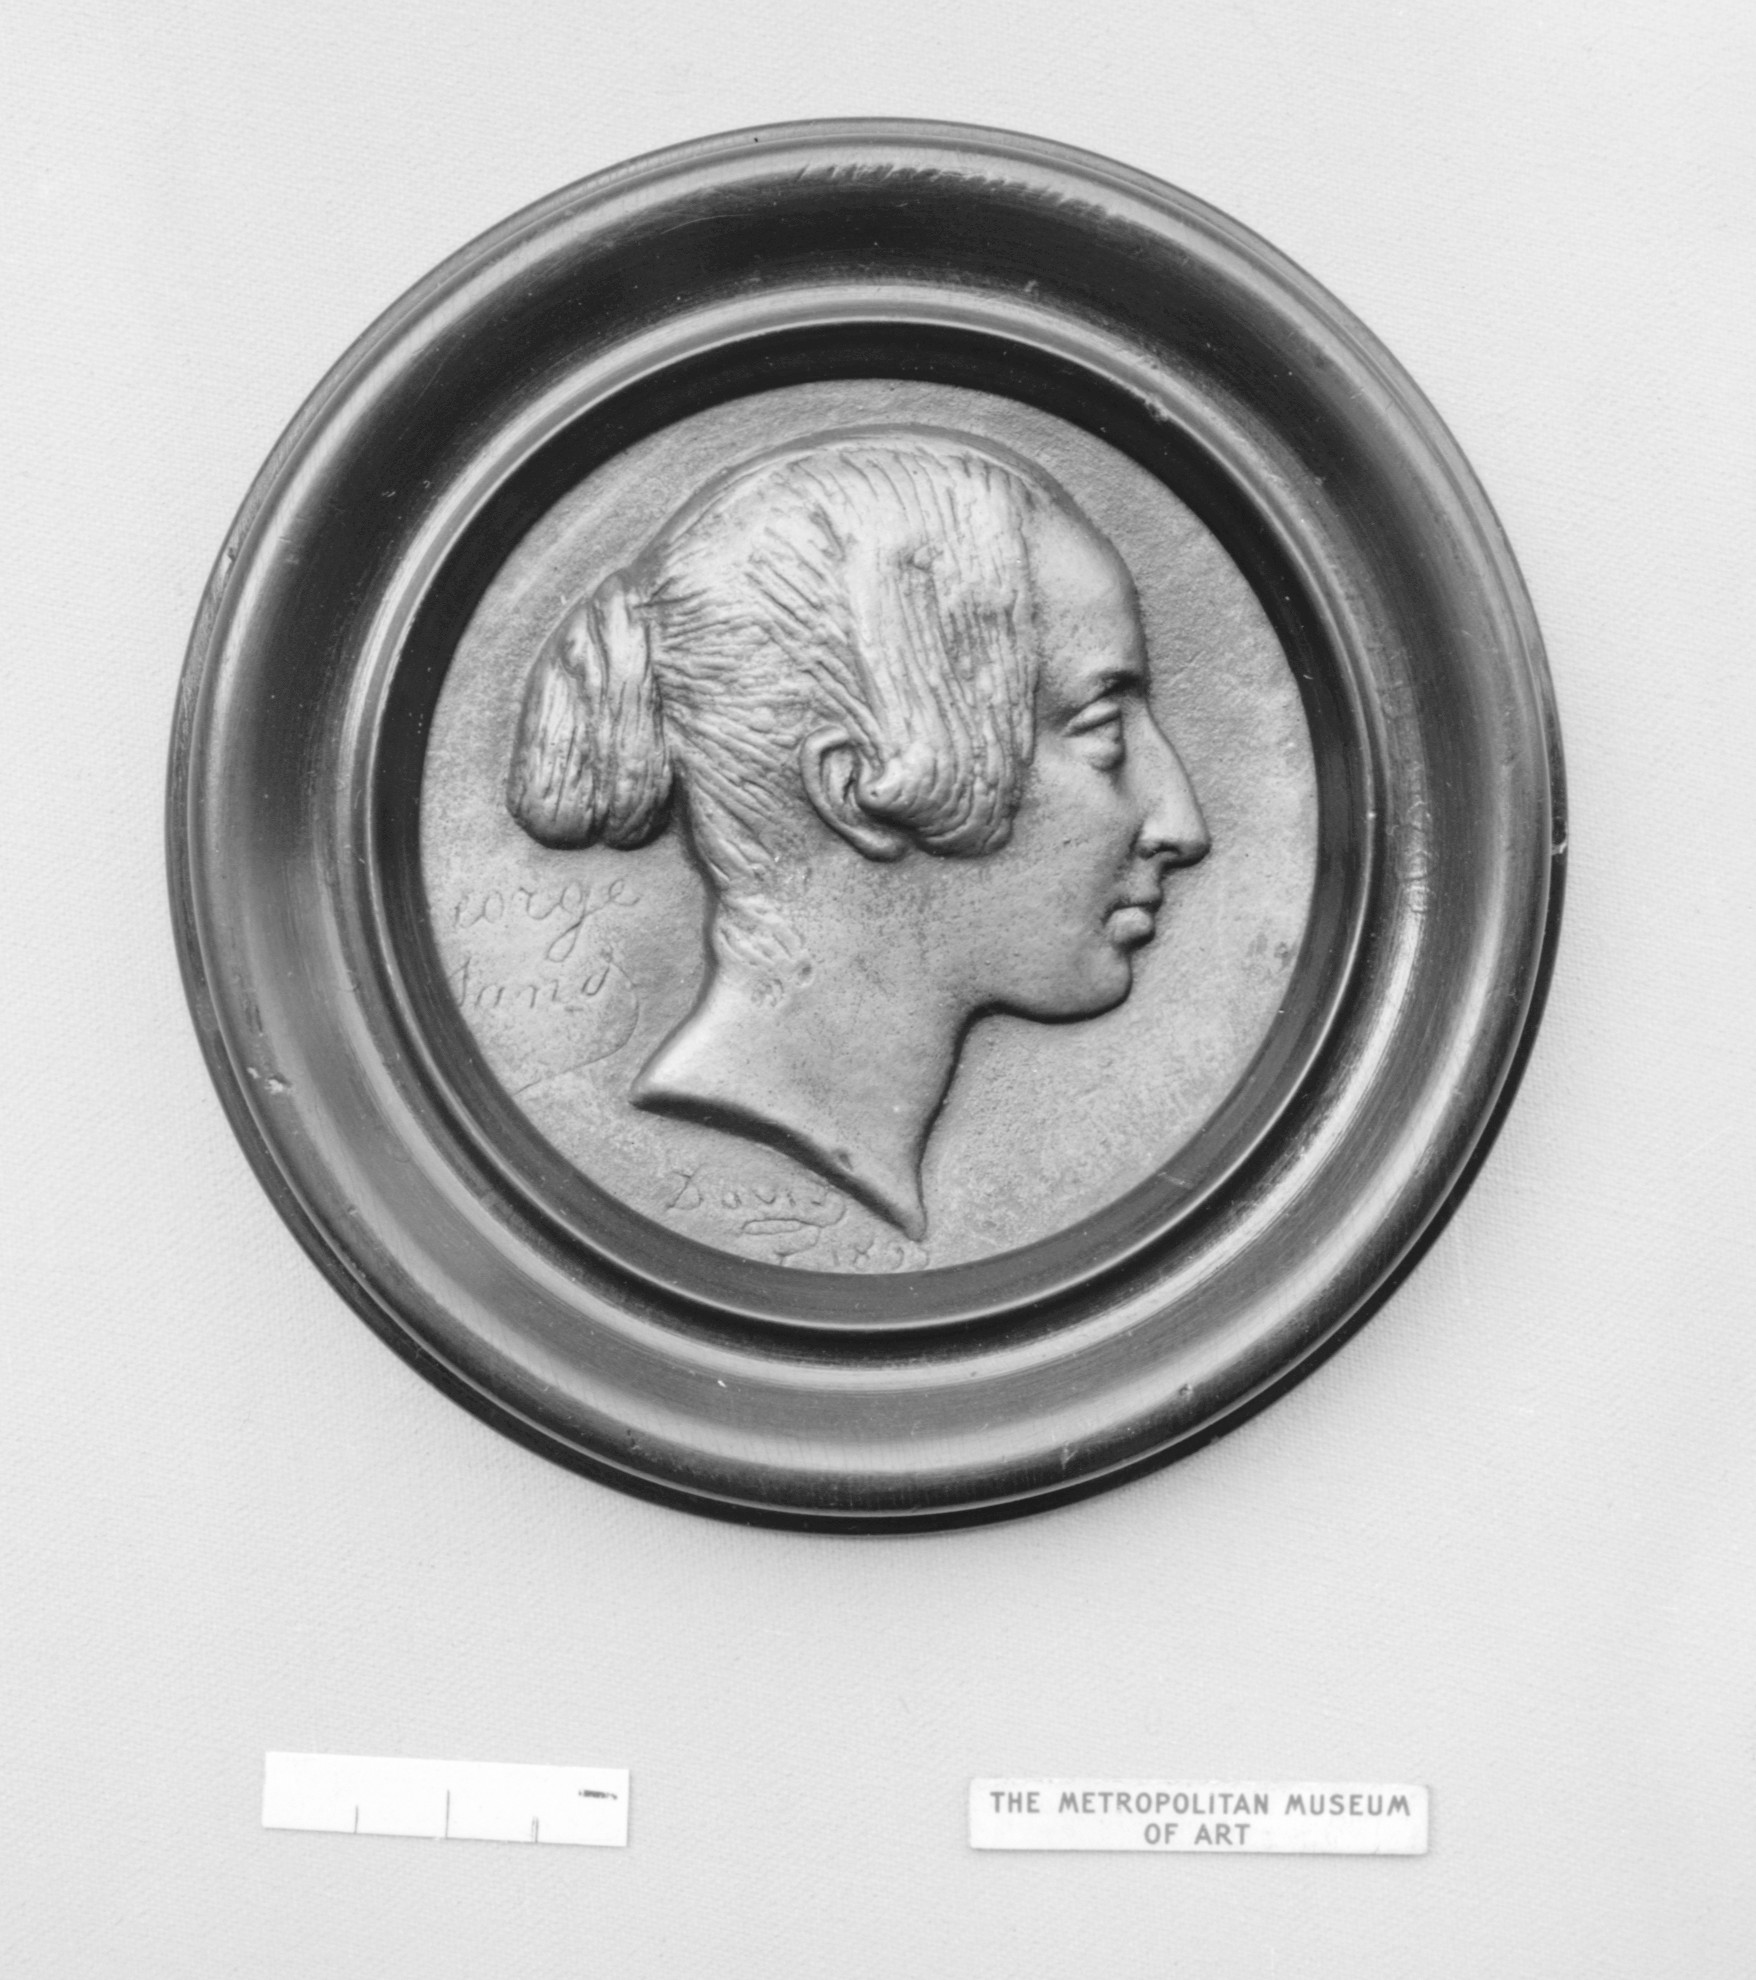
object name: medallion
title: George Sand (Armandine Lucile Aurore Dupin, Baroness Dudevant), French novelist (1804–1876)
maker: pierre jean david d'angers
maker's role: artist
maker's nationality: french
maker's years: 1788-1856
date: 1830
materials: bronze, patina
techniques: casting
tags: profiles,women